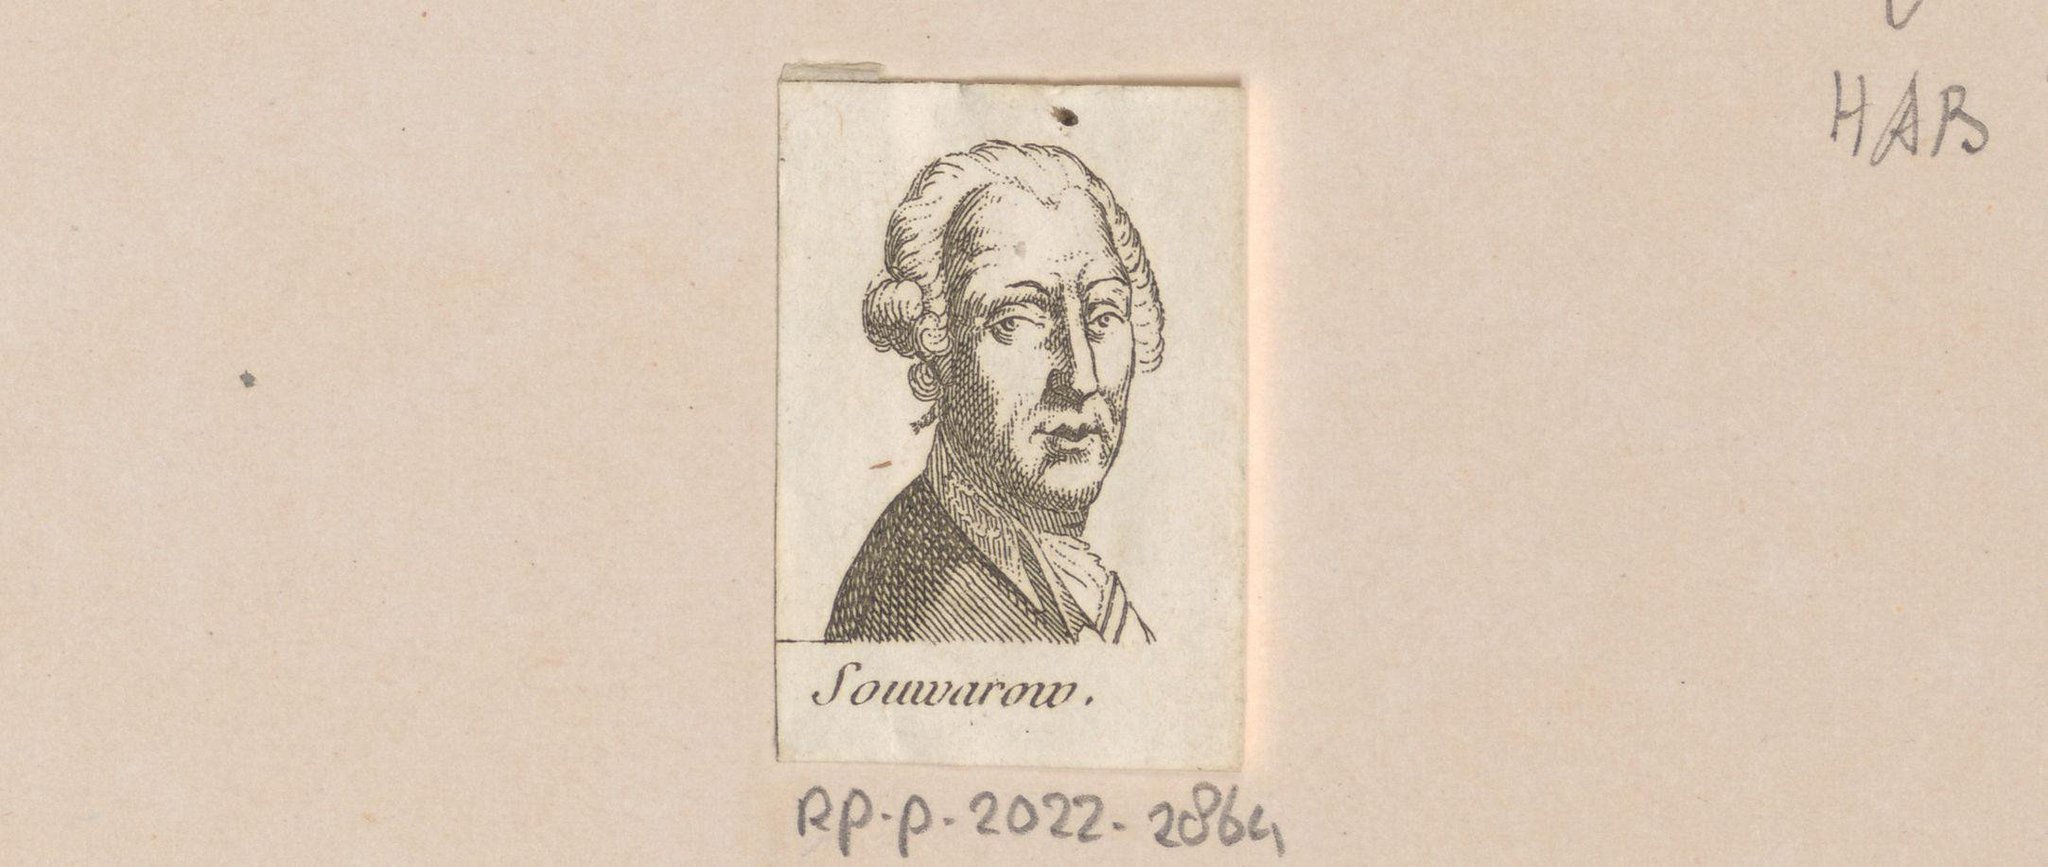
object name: print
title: Portret van Aleksandr Soevorov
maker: Anonymous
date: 1762-1899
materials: paper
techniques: etching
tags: commander-in-chief, general, marshal, historical persons